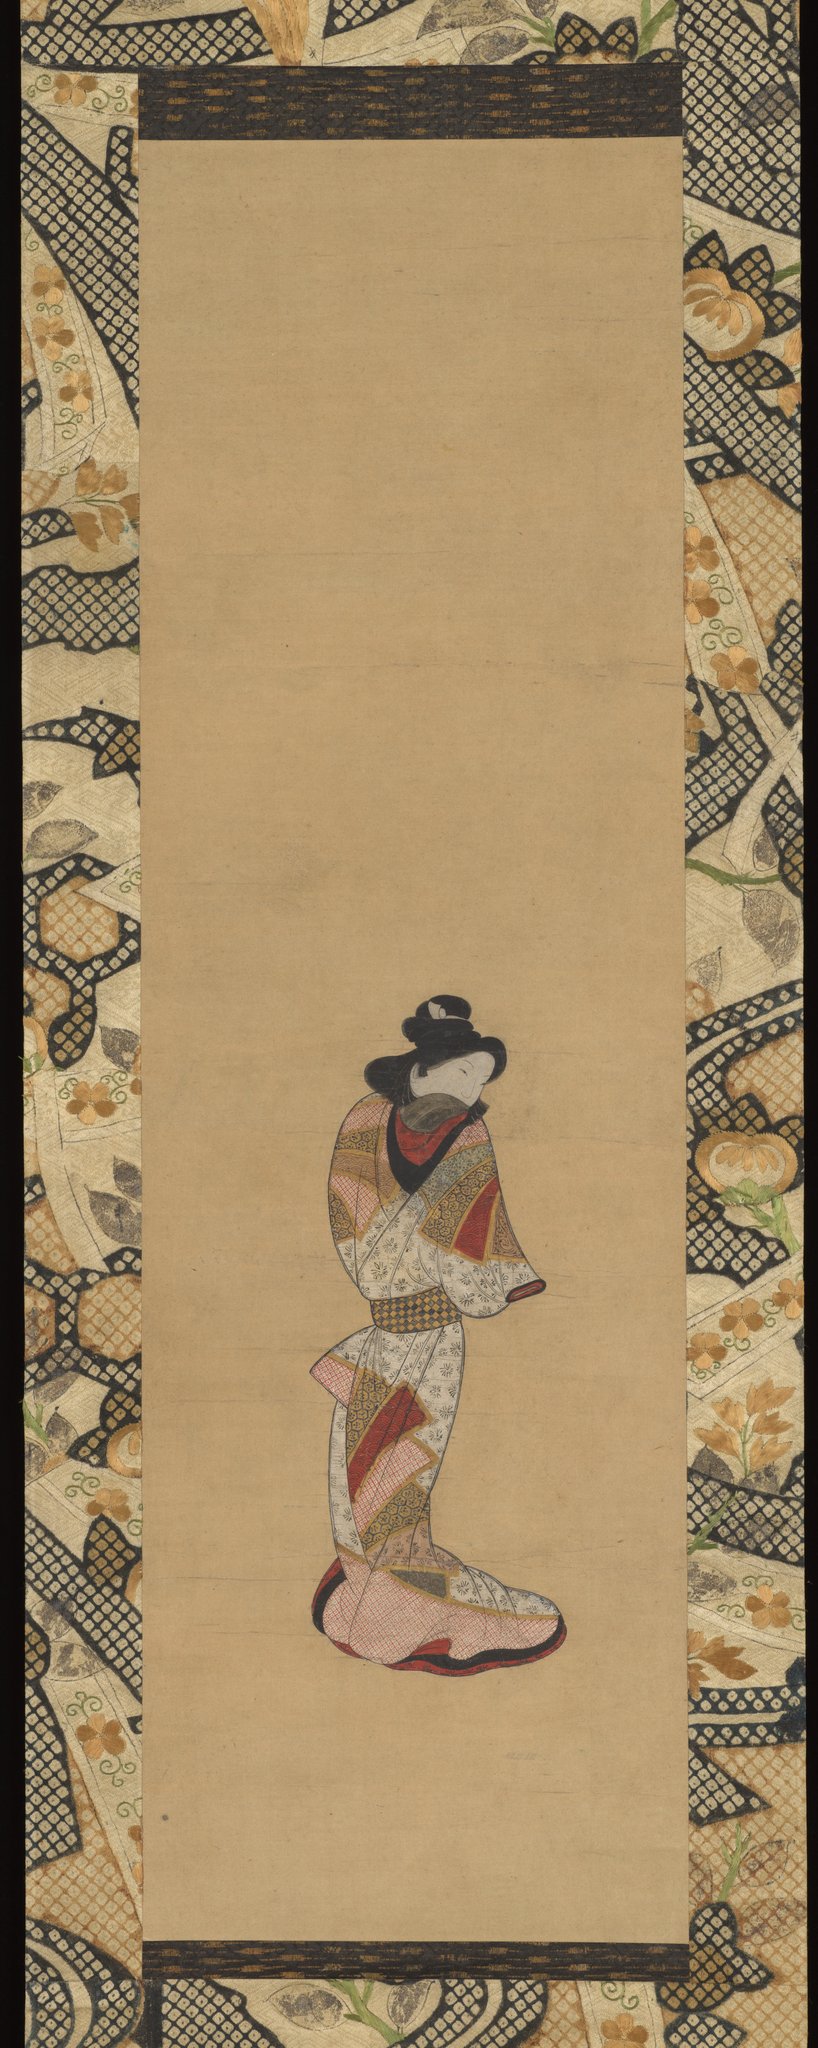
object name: hanging scroll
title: Beauty of the Kanbun Era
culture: japanese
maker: unidentified artist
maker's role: artist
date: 1667-1700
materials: ink, paper